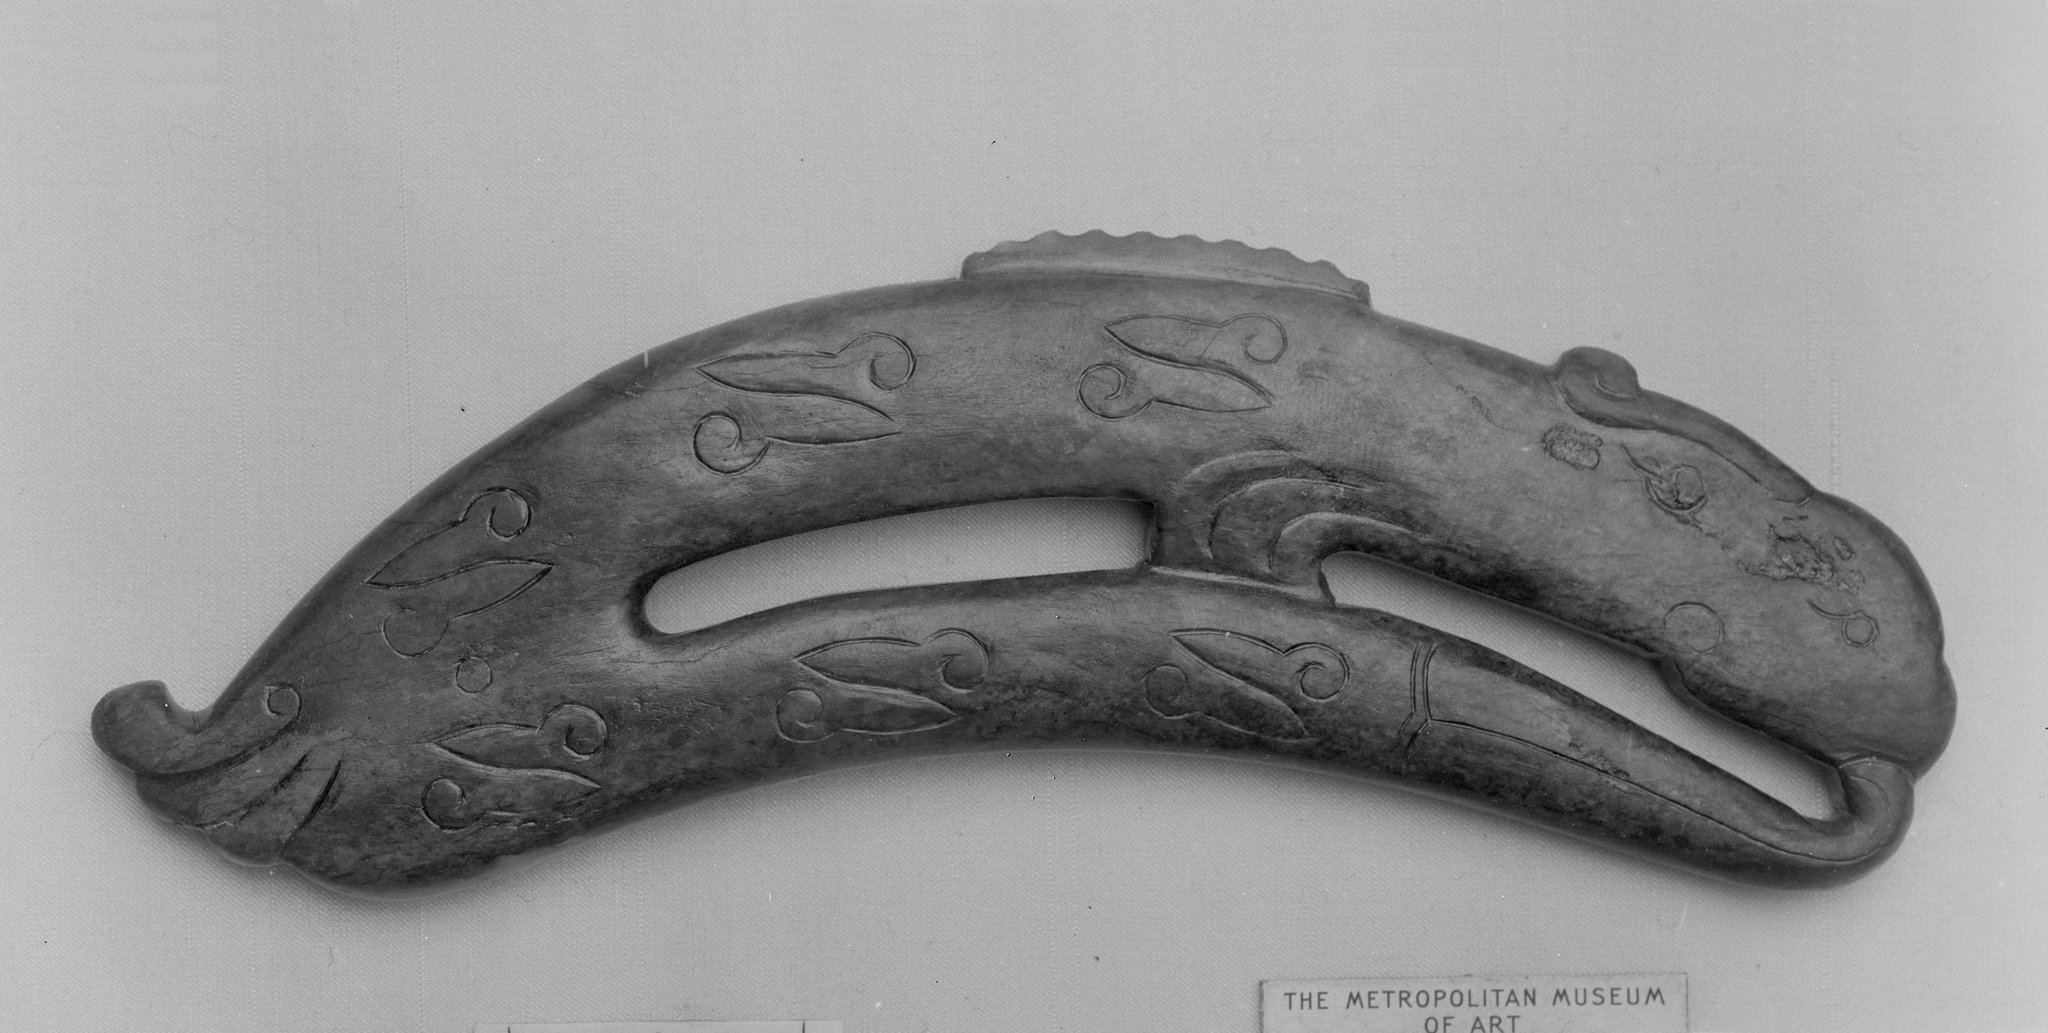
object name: pendant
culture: chinese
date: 1867-1933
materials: jade